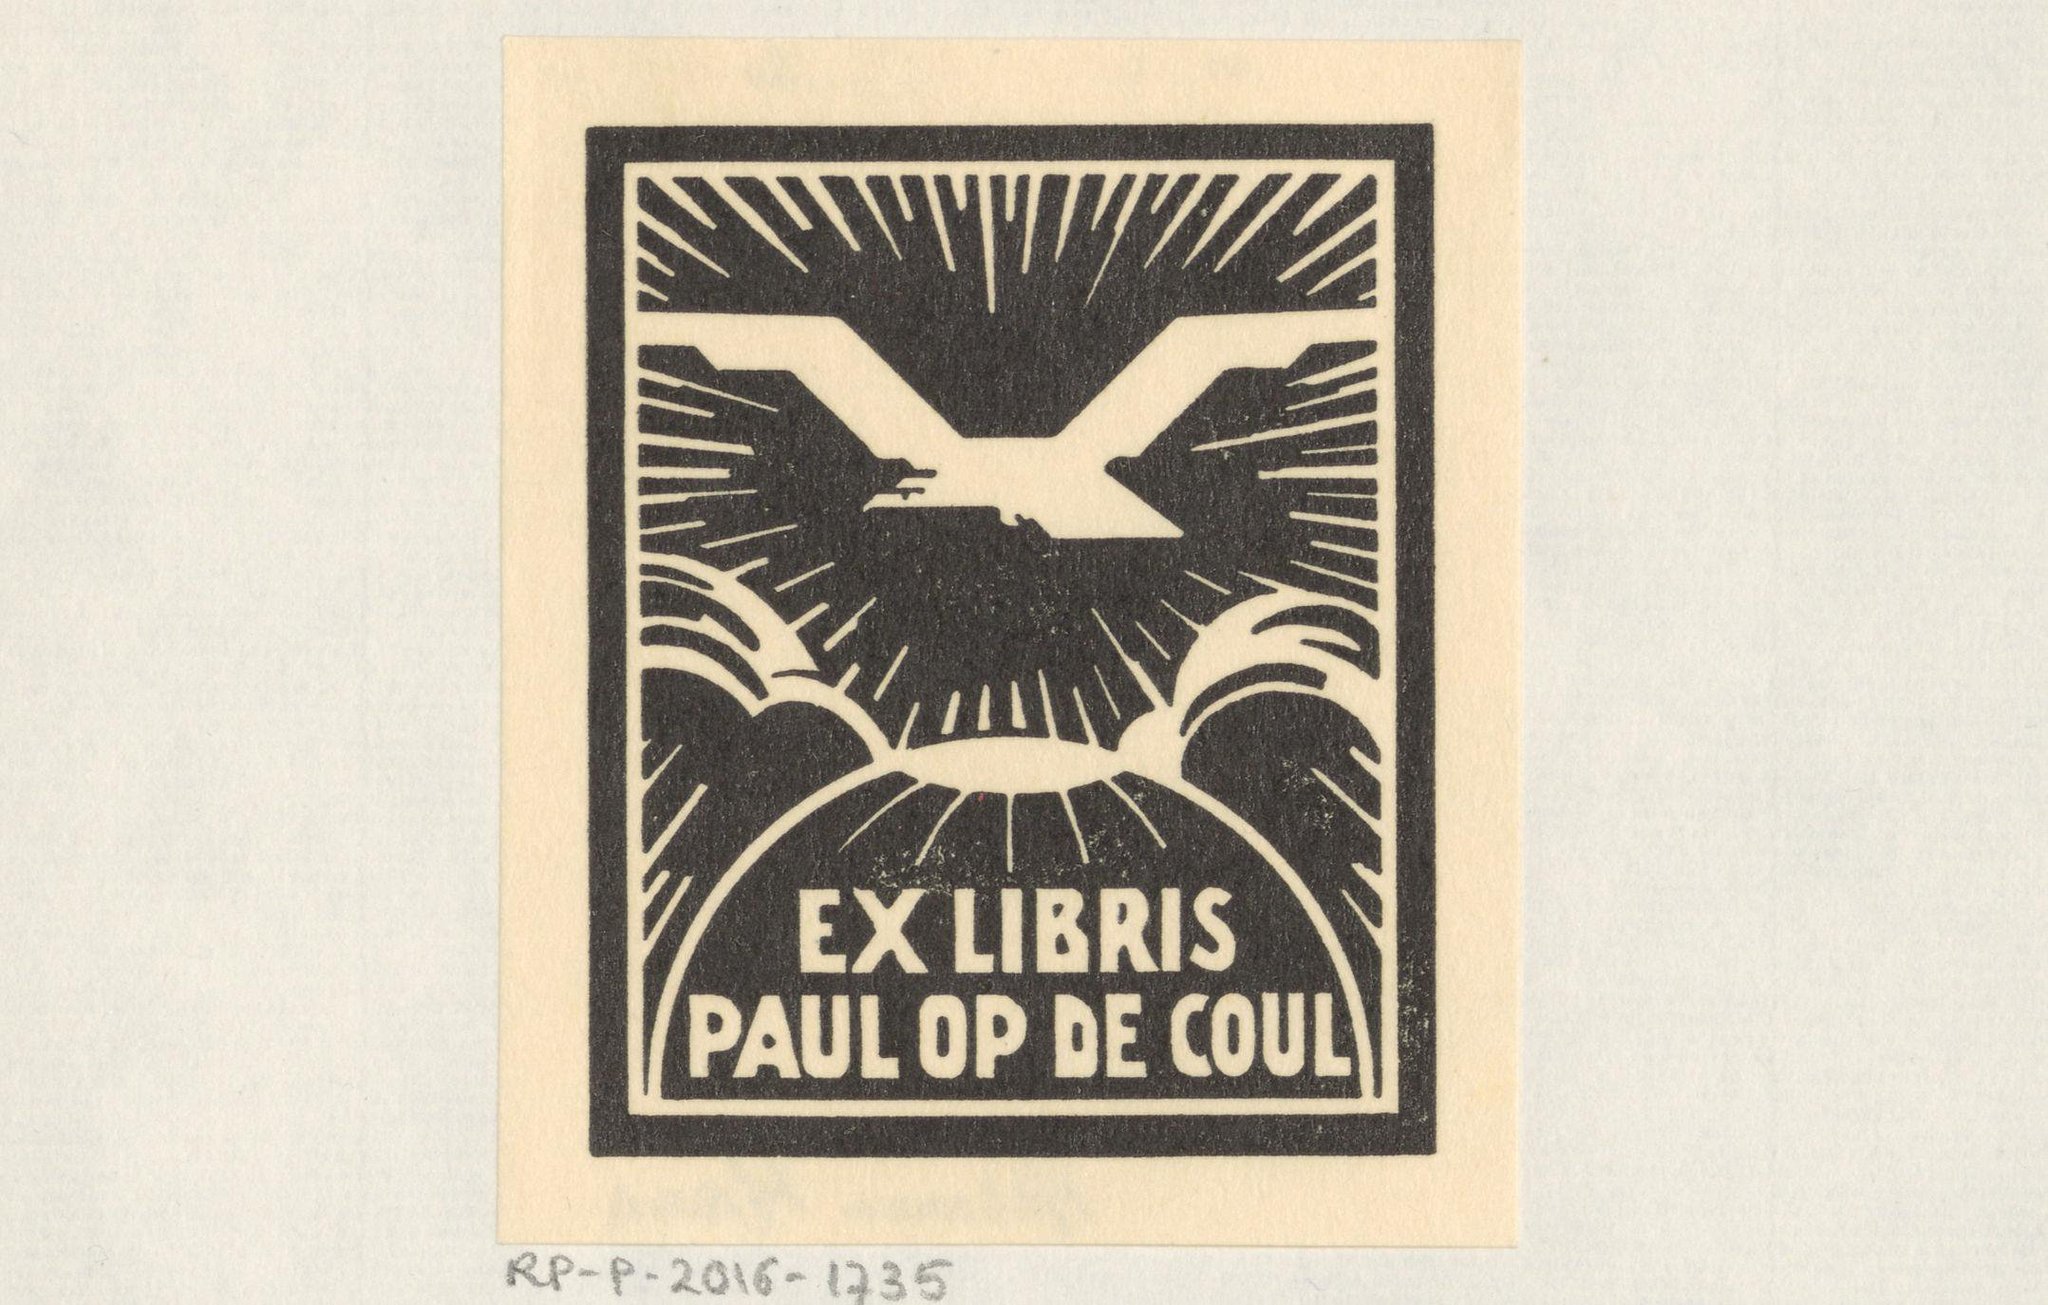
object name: bookplate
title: Ex libris van Paul Op de Coul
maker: herman hana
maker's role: painter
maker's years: 1874-1952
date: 1884-1952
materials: paper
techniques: engraving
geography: netherlands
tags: predatory birds: eagle, globe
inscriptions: inscription: ‘Herman Hana’